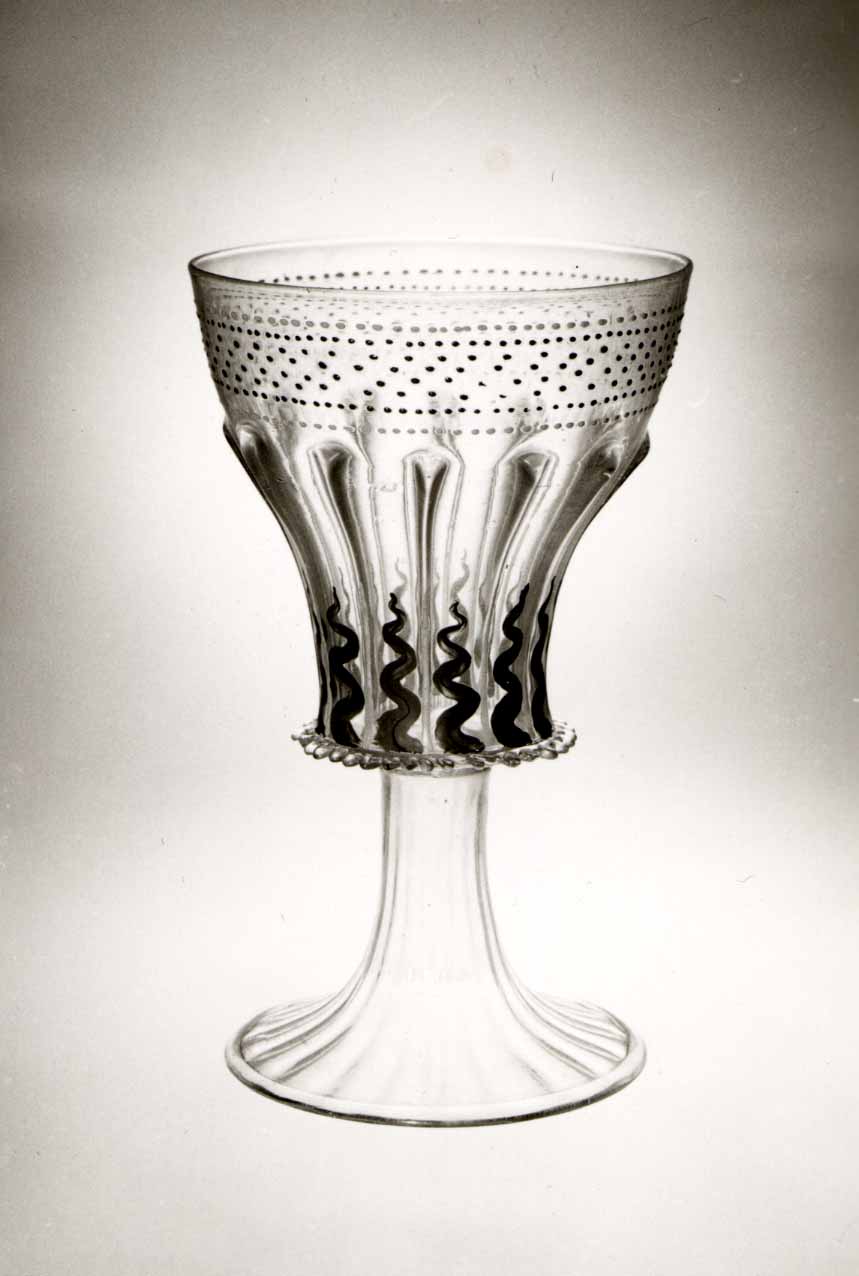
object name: goblet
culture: italian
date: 1500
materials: gilt, glass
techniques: glassblowing, enamel, molding